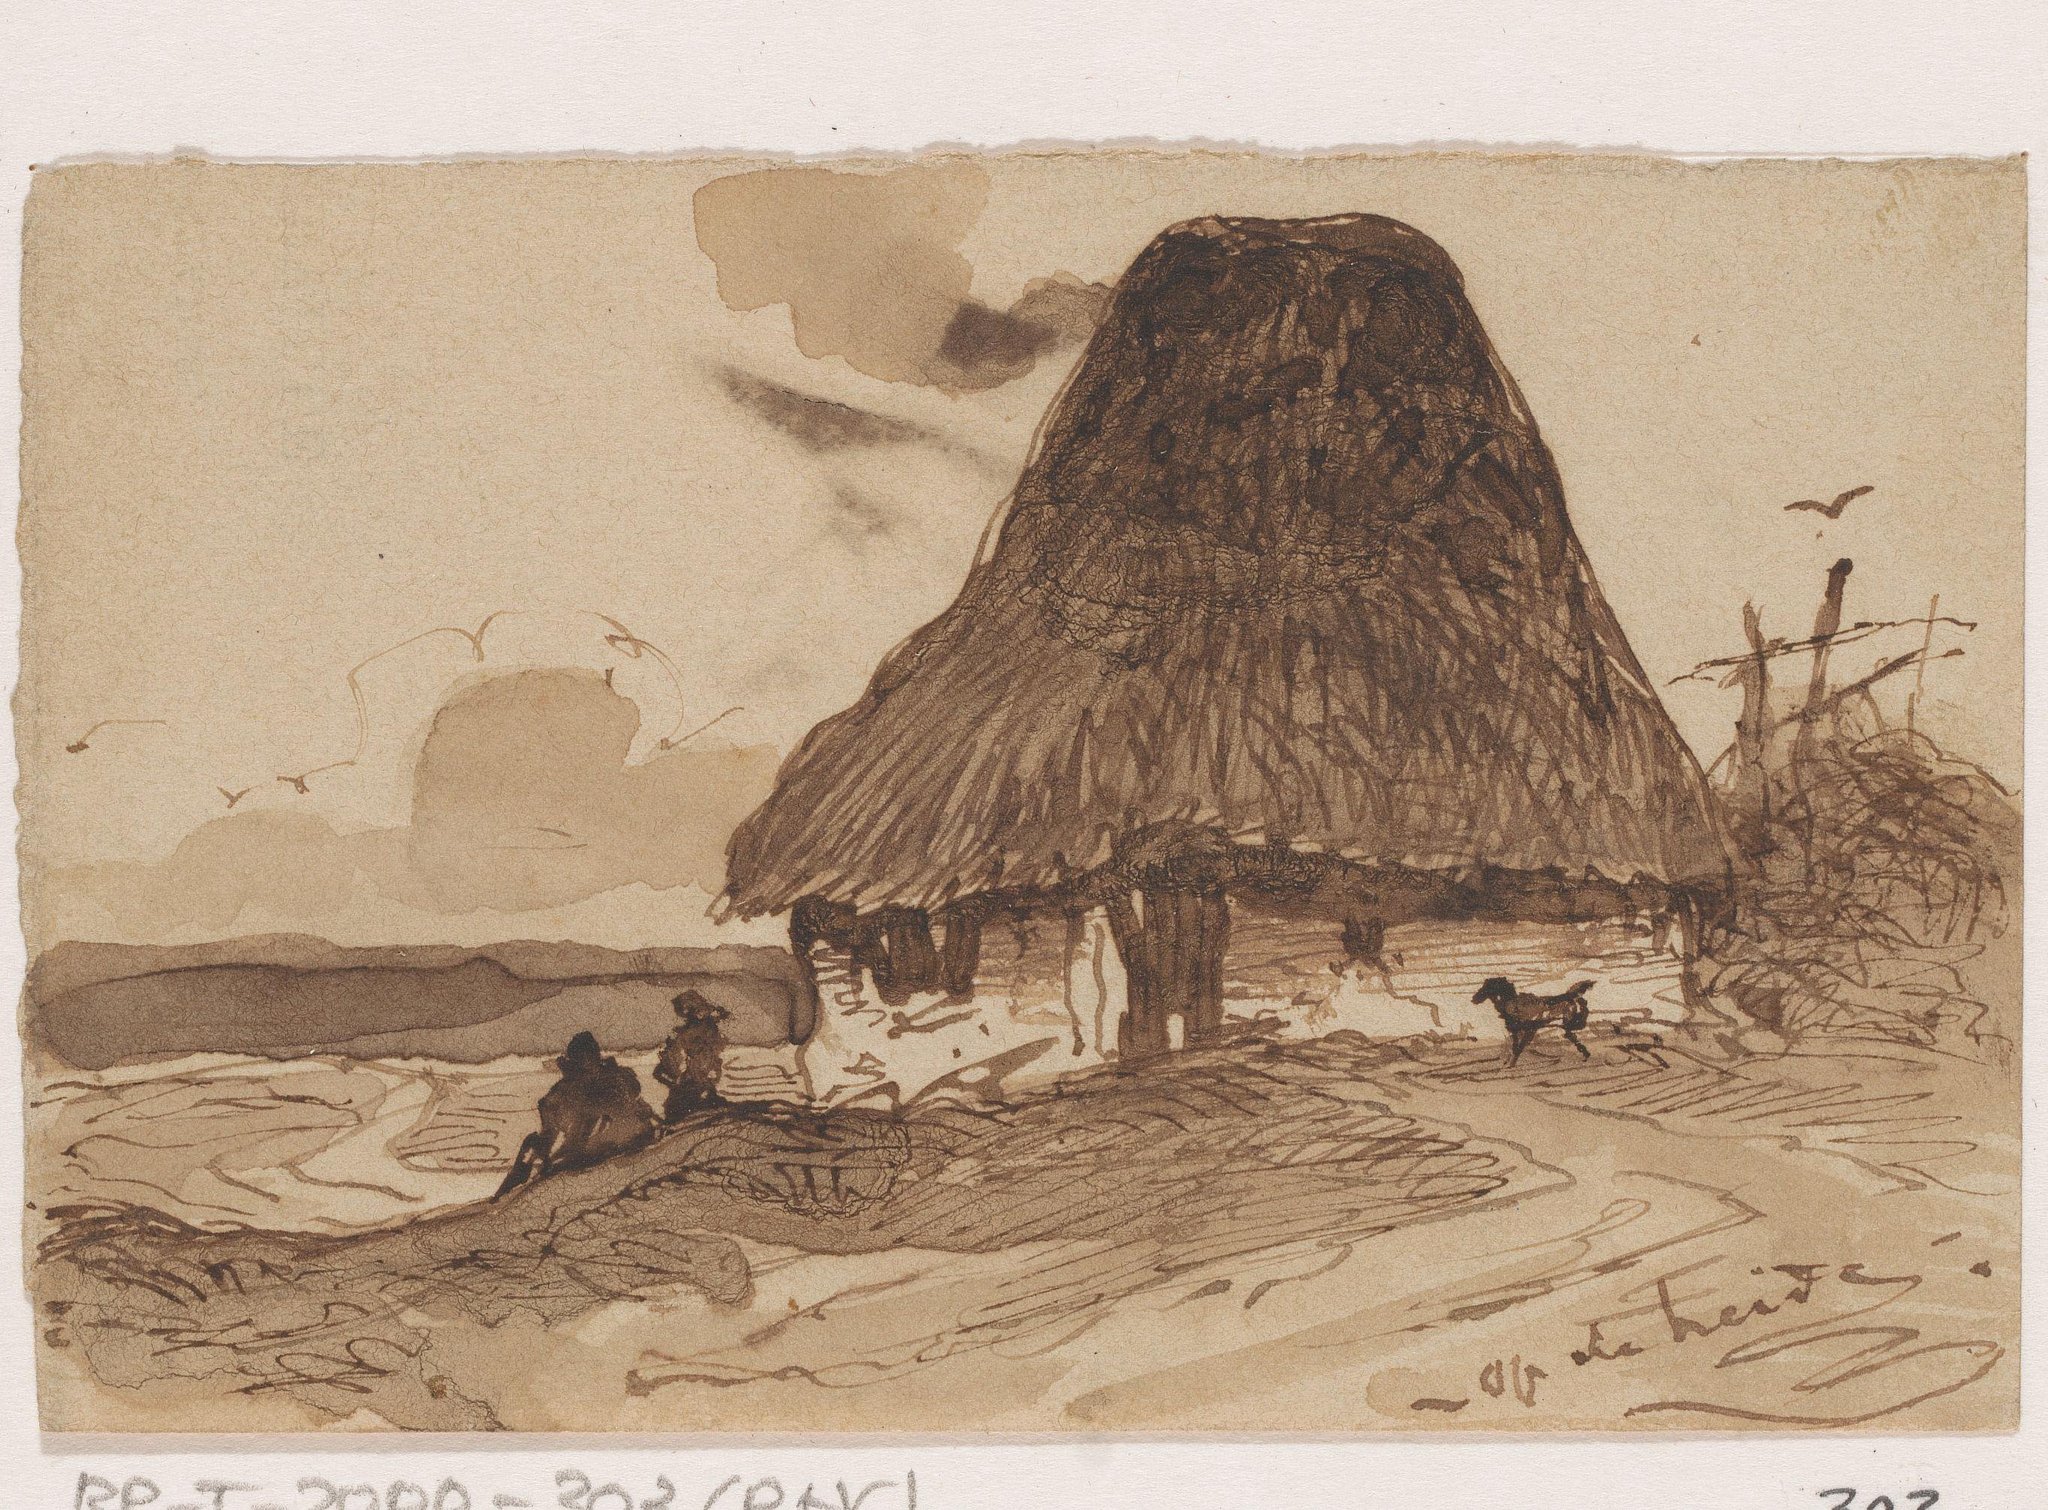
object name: drawing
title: Op de heide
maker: johannes tavenraat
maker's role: draughtsman, painter, print maker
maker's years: 1809-1881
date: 1874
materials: ink, paper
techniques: brush, pen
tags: village (+ city(-scape) with figures, staffage)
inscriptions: annotation: ‘op de heide’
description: Enkele personen zittend bij een huis met rieten dak, op de heide.